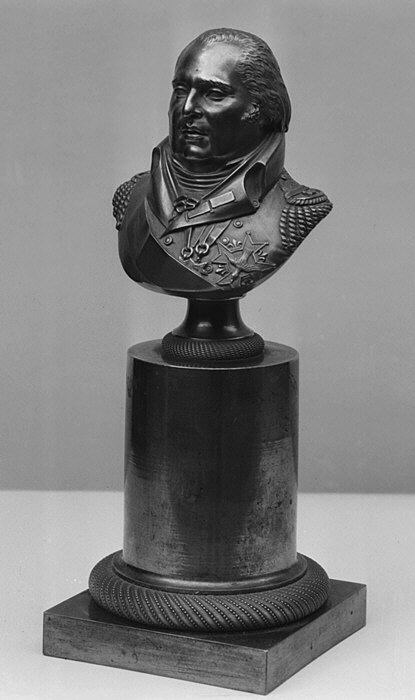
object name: bust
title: Louis XVIII of France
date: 1815-1825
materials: gilt bronze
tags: kings